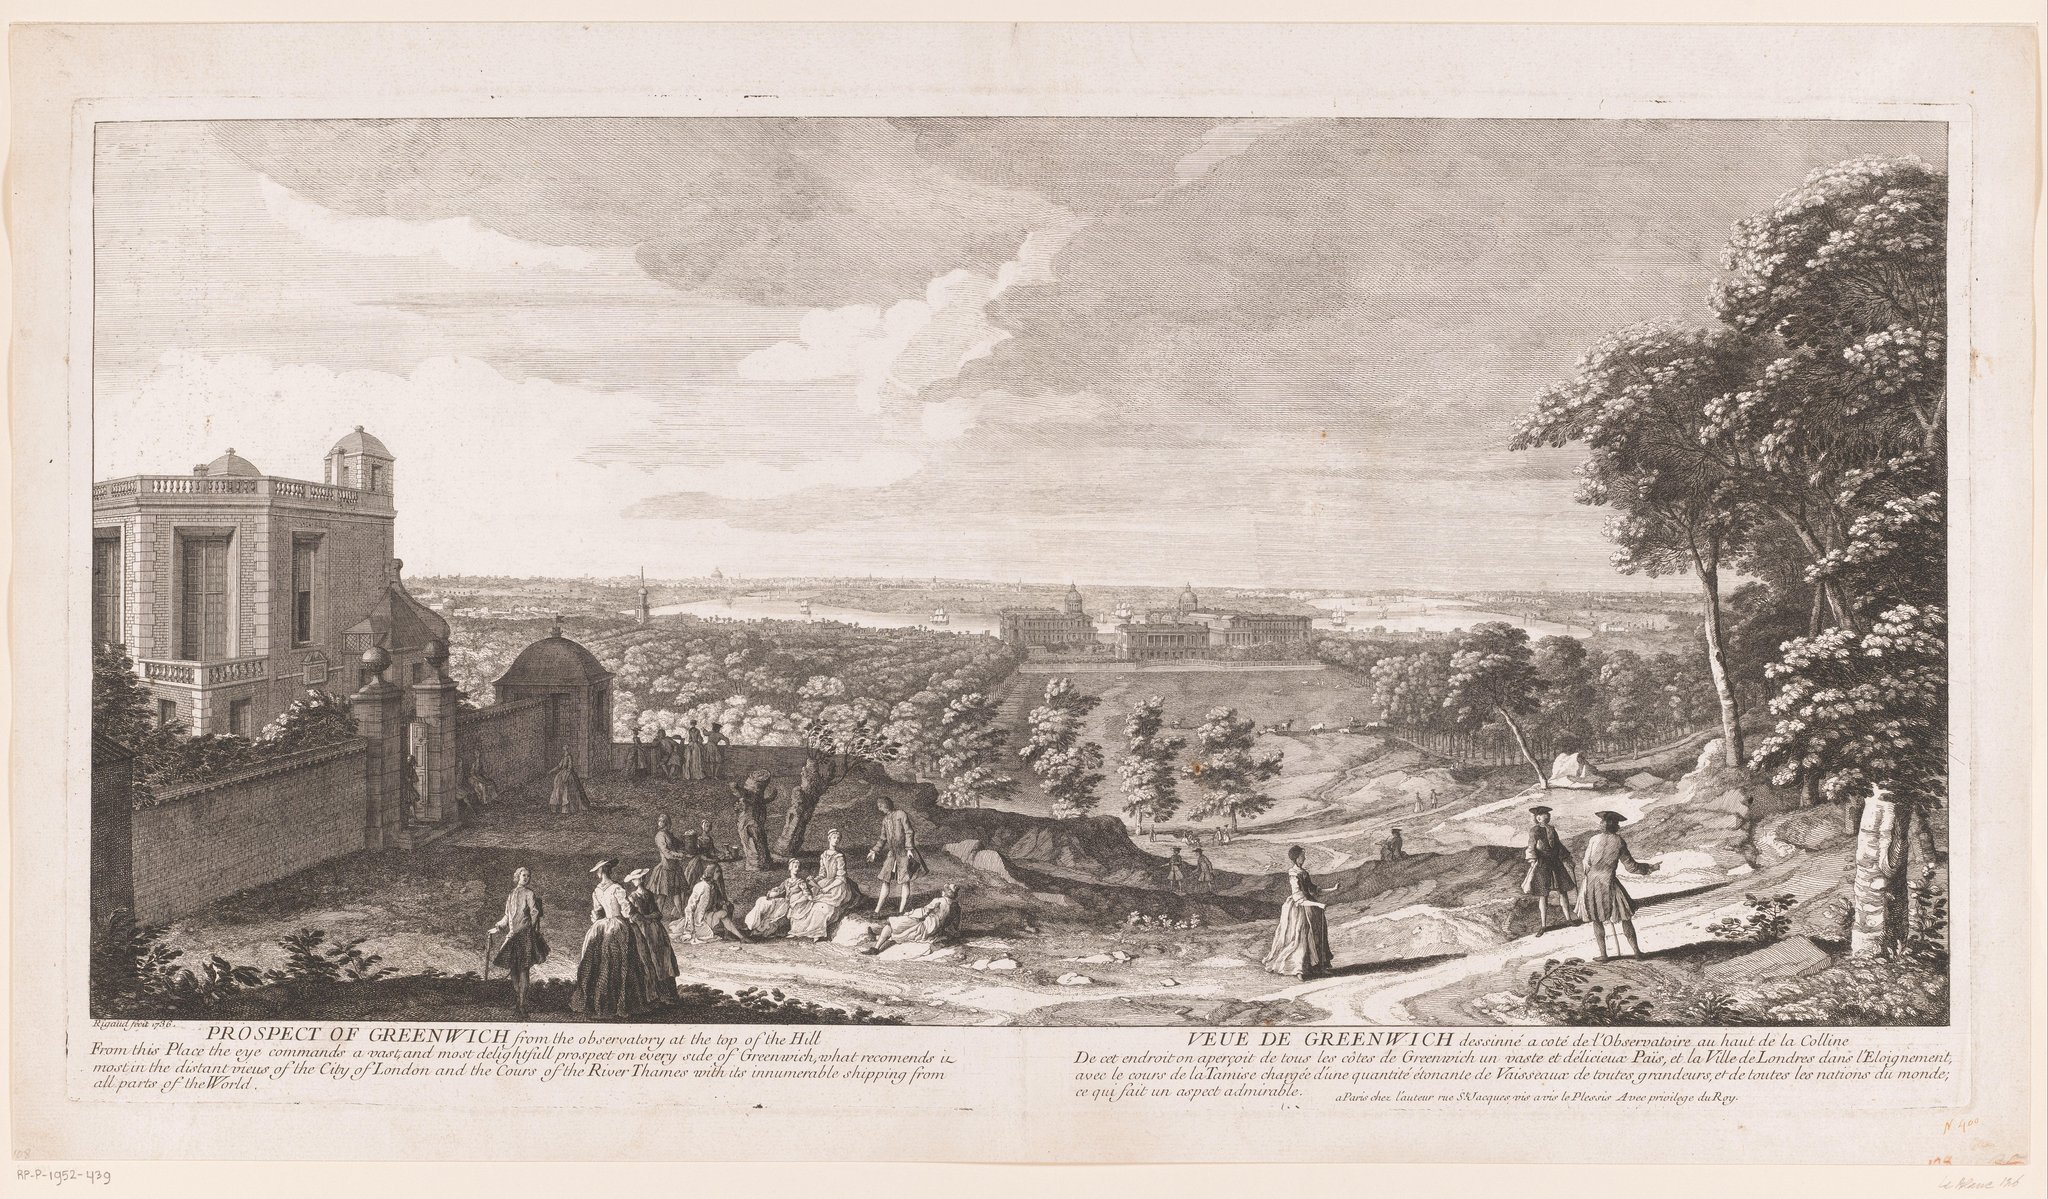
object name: print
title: Prospect of Greenwich / Veue de Greenwich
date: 1736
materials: paper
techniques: etching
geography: paris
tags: city-view in general; 'veduta'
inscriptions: collector's mark: Lugt 2228